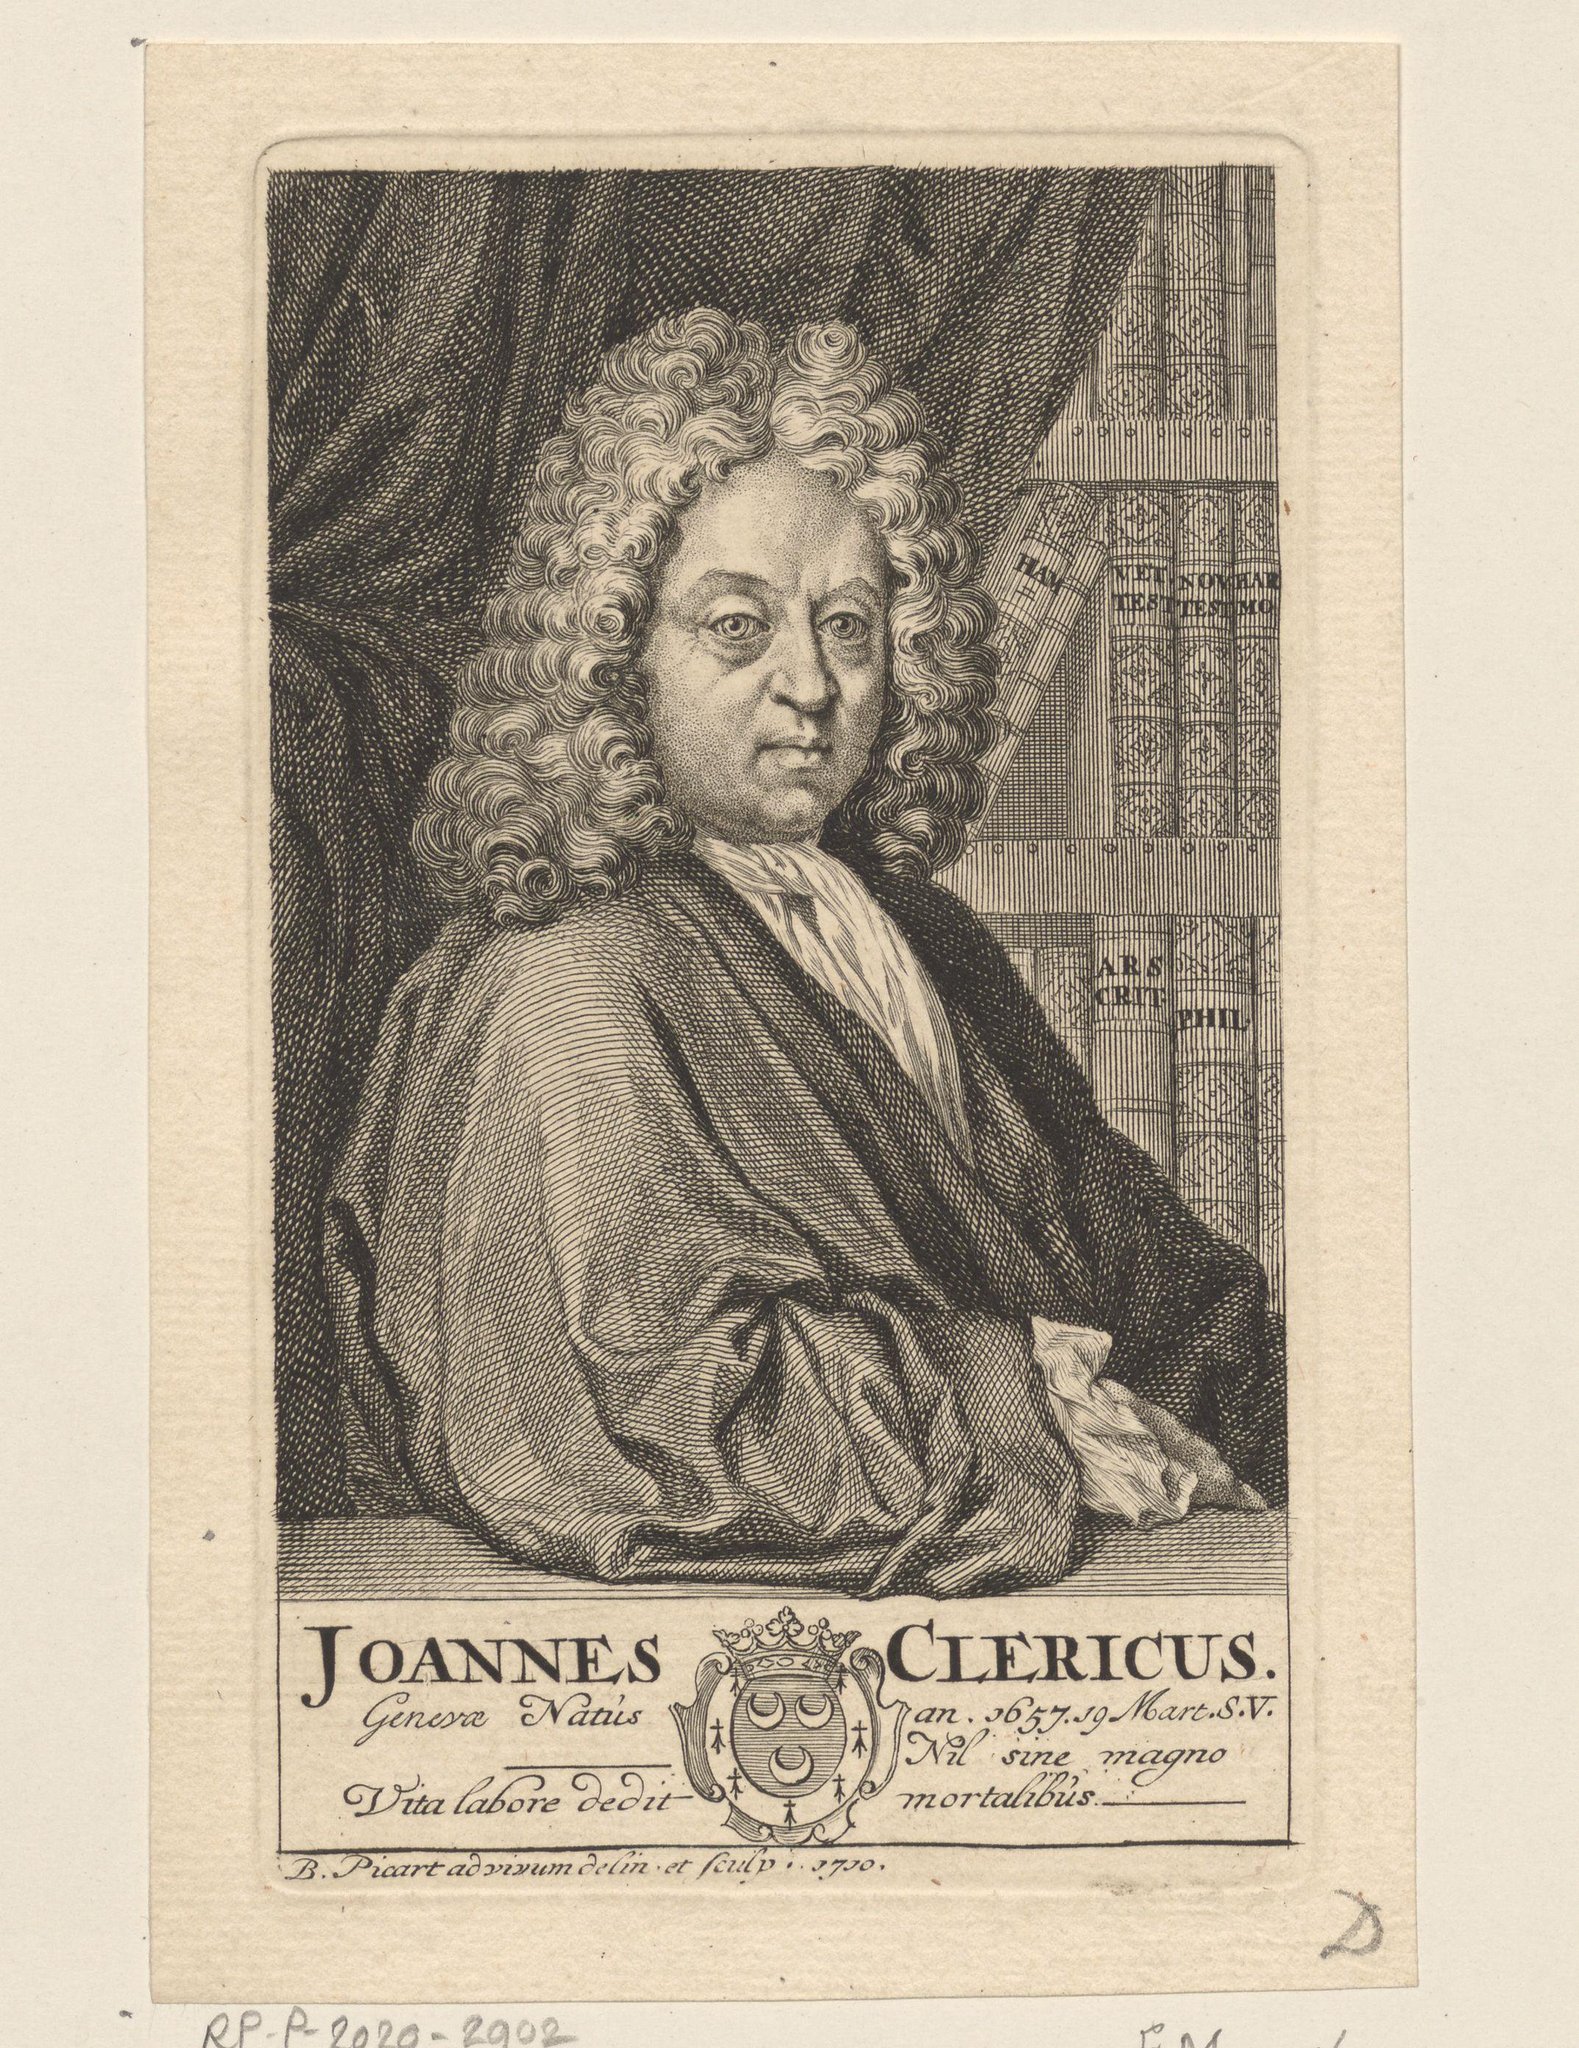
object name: print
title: Portret van Jean le Clerc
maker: bernard picart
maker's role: draughtsman, print maker, publisher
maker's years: 1673-1733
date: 1730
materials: paper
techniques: engraving, etching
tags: jean le clerc (1657-1736), historical persons, book, armorial bearing, heraldry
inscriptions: date